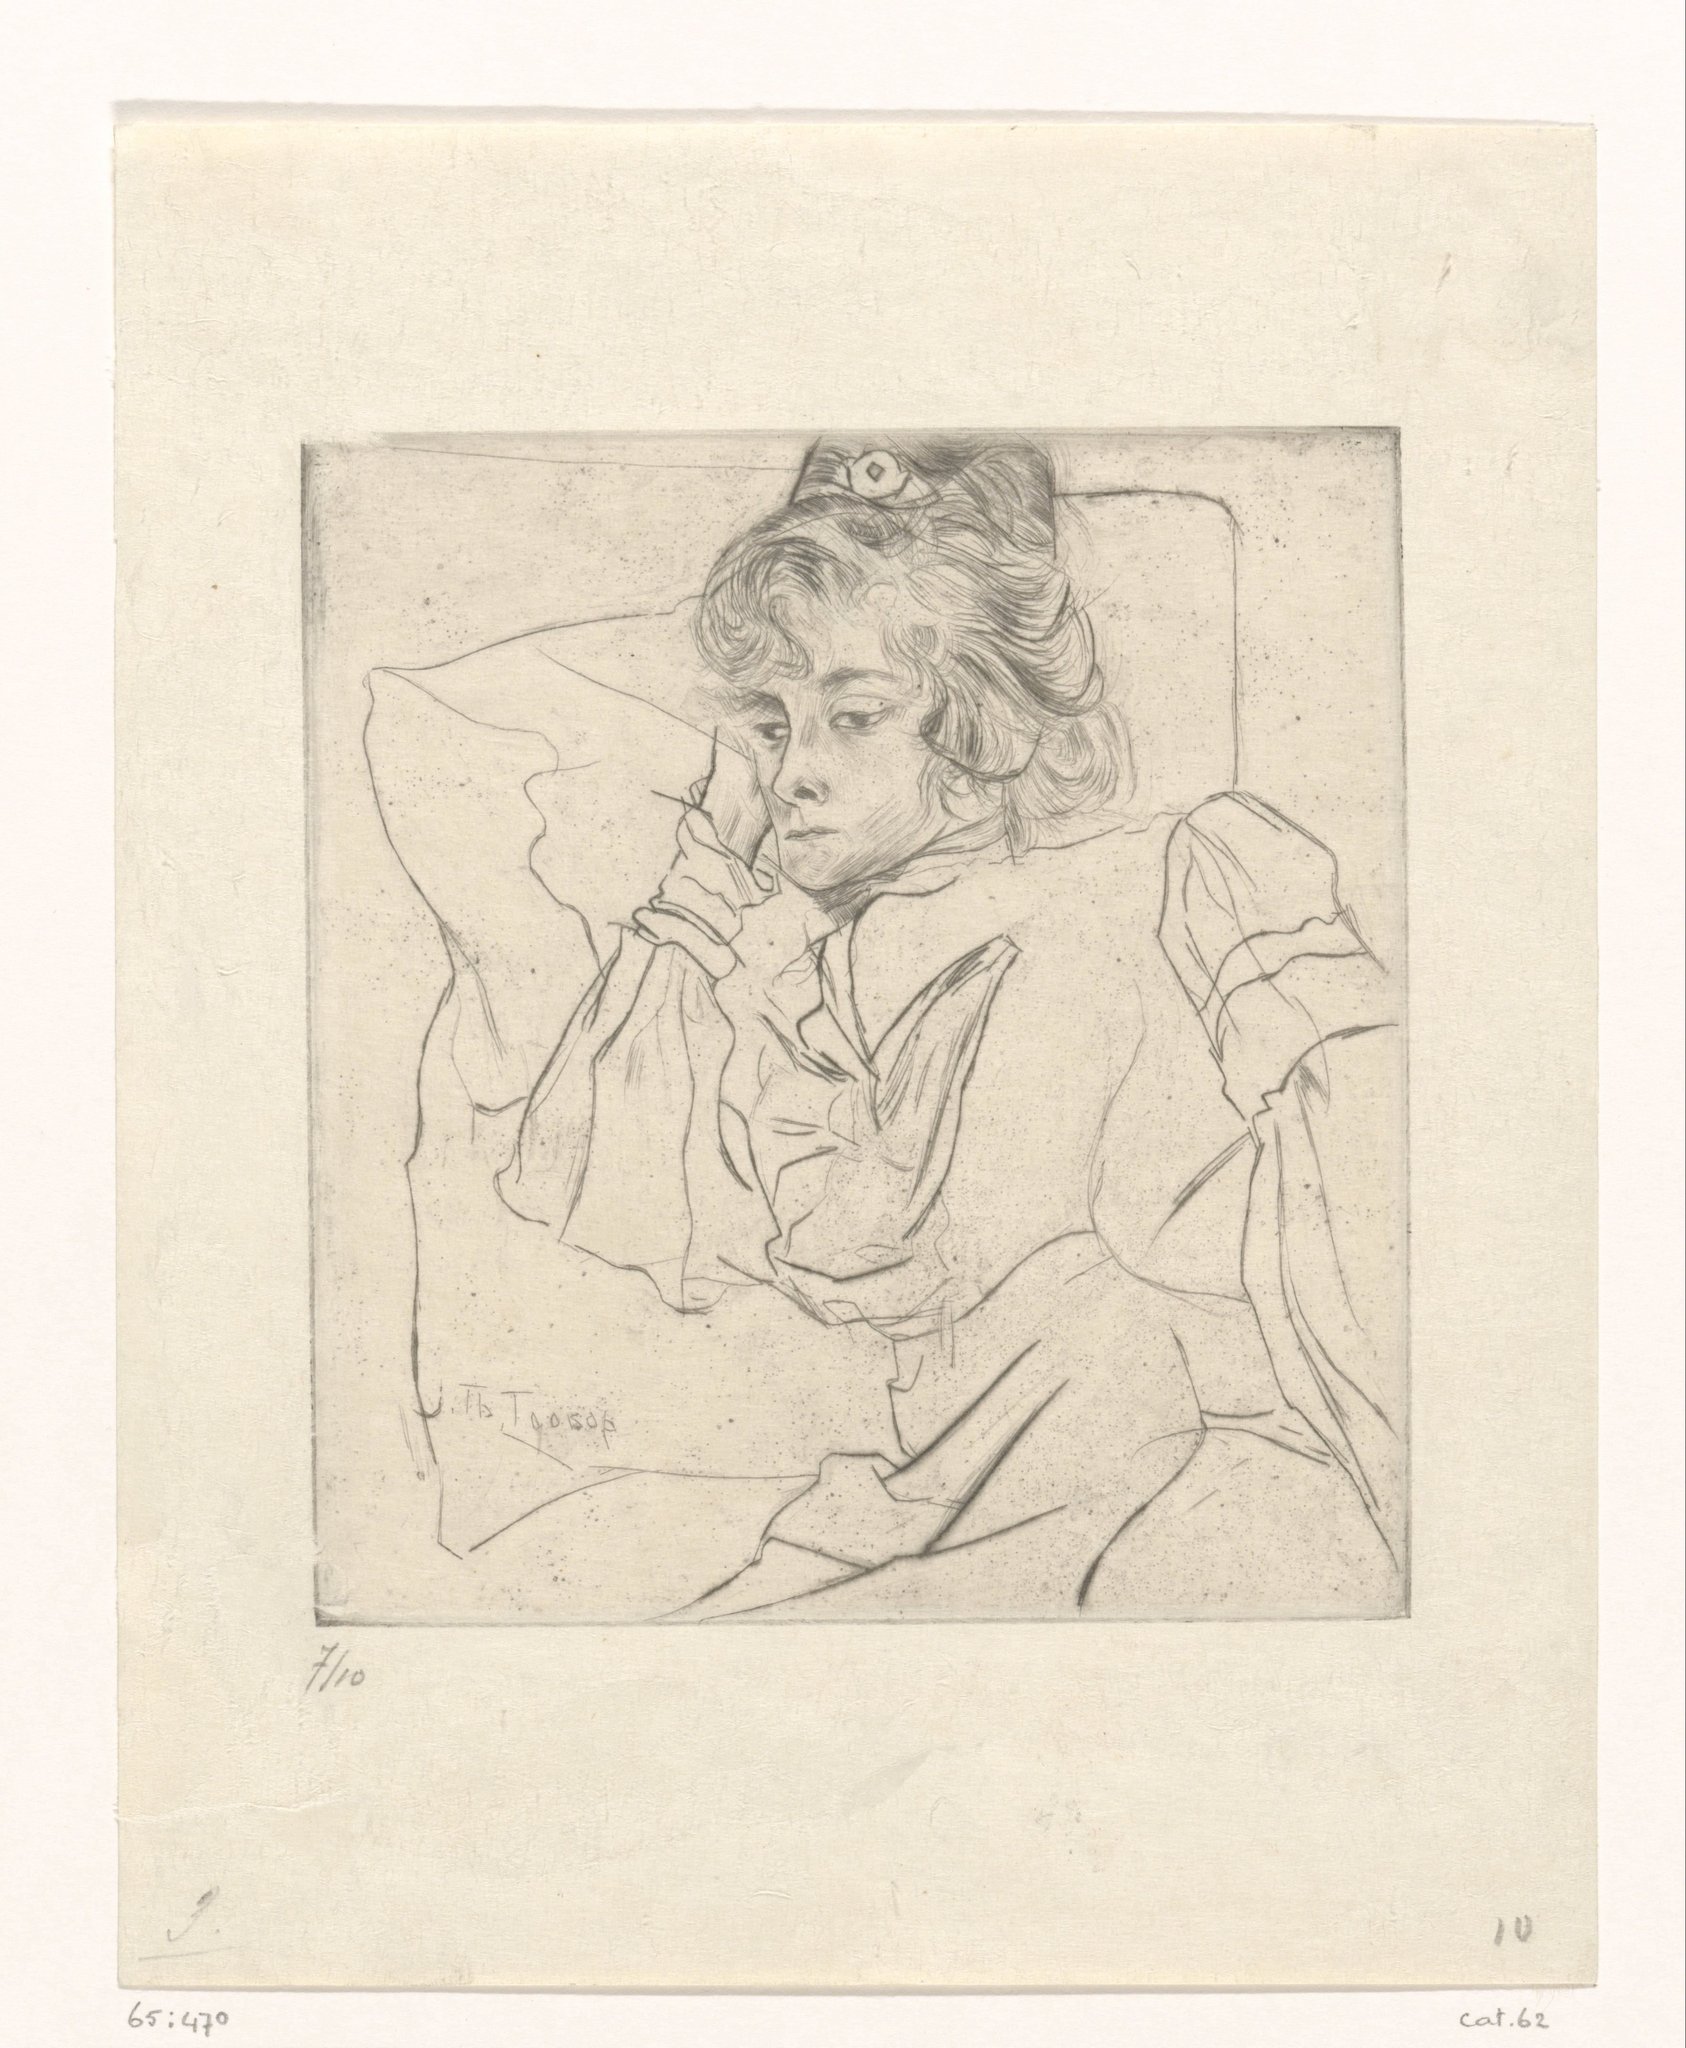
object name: print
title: Jonge vrouw leunend tegen een kussen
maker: jan toorop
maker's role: draughtsman, painter, print maker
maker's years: 1858-1928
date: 1901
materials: paper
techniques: drypoint, intaglio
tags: cushion, adult woman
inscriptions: collector's mark: Lugt 2228, collector's mark: Lugt 2760